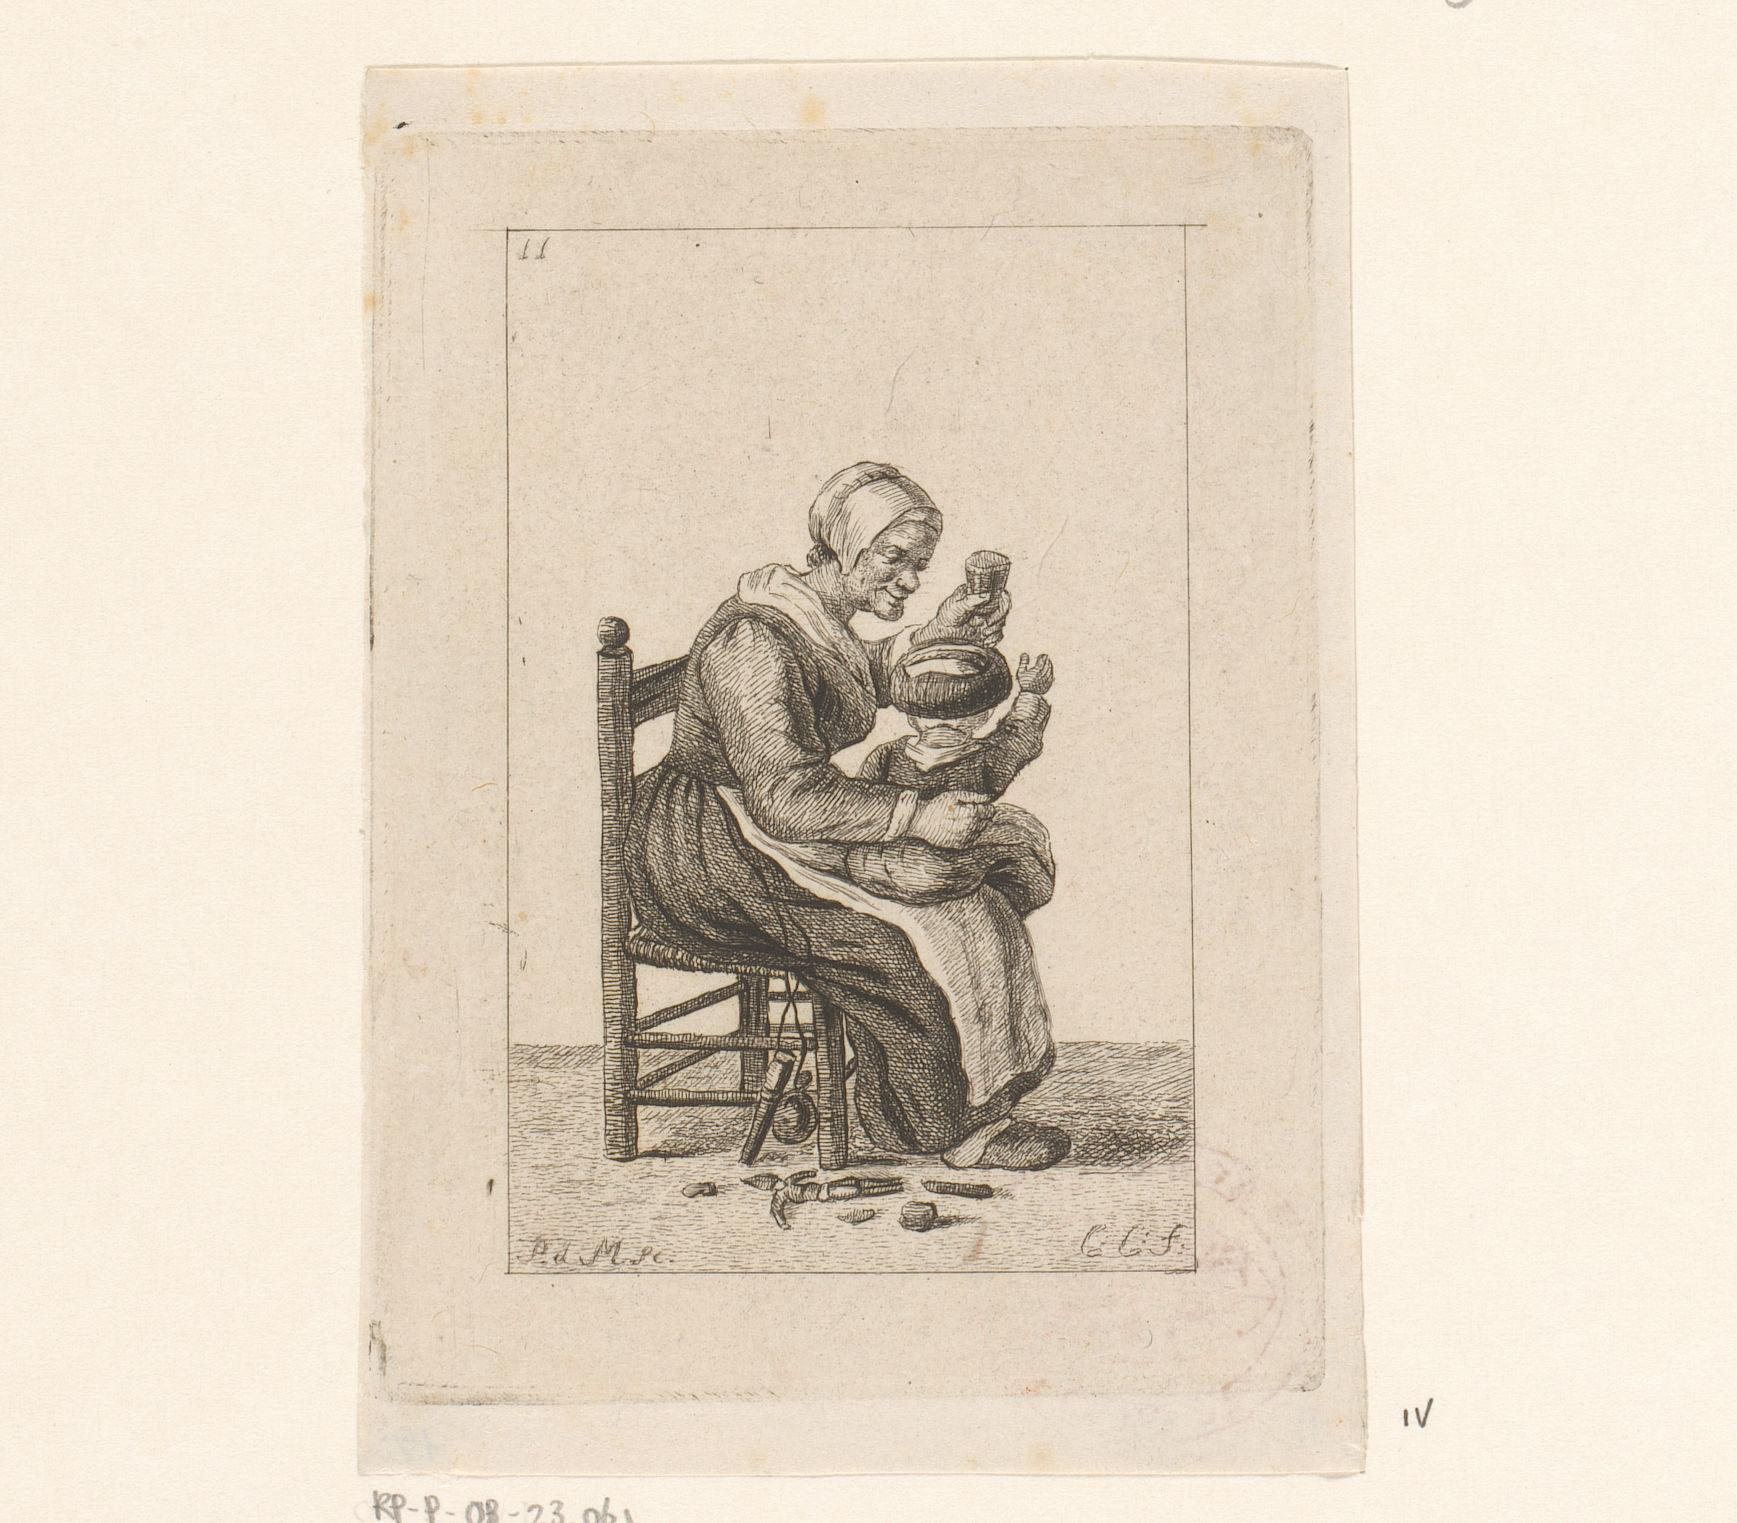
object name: print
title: Vrouw met kind op schoot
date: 1779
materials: paper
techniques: etching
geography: leiden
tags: mother and baby or young child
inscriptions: collector's mark: Lugt 240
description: Een zittende vrouw met een kind op schoot.